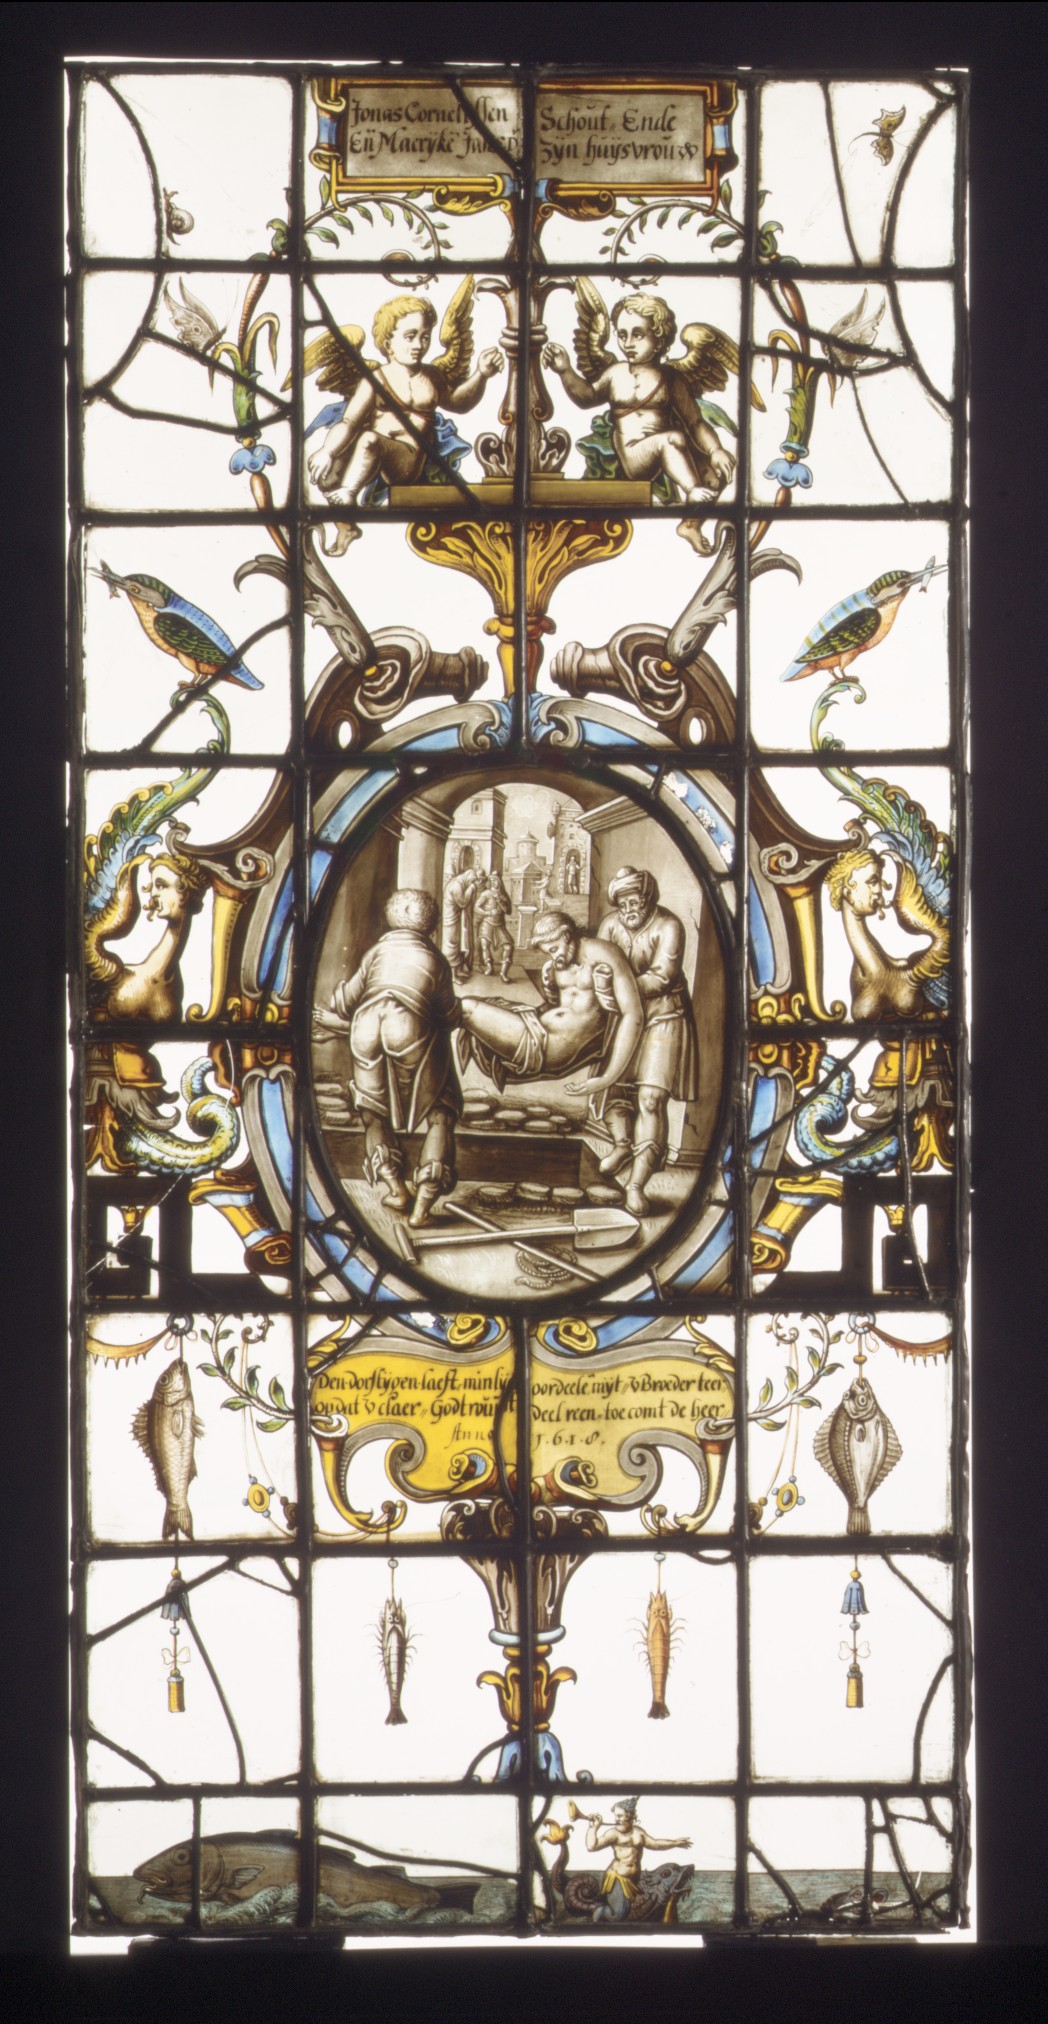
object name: panel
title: Burying the Dead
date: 1618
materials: glass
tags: men,putti,fish,burials,death